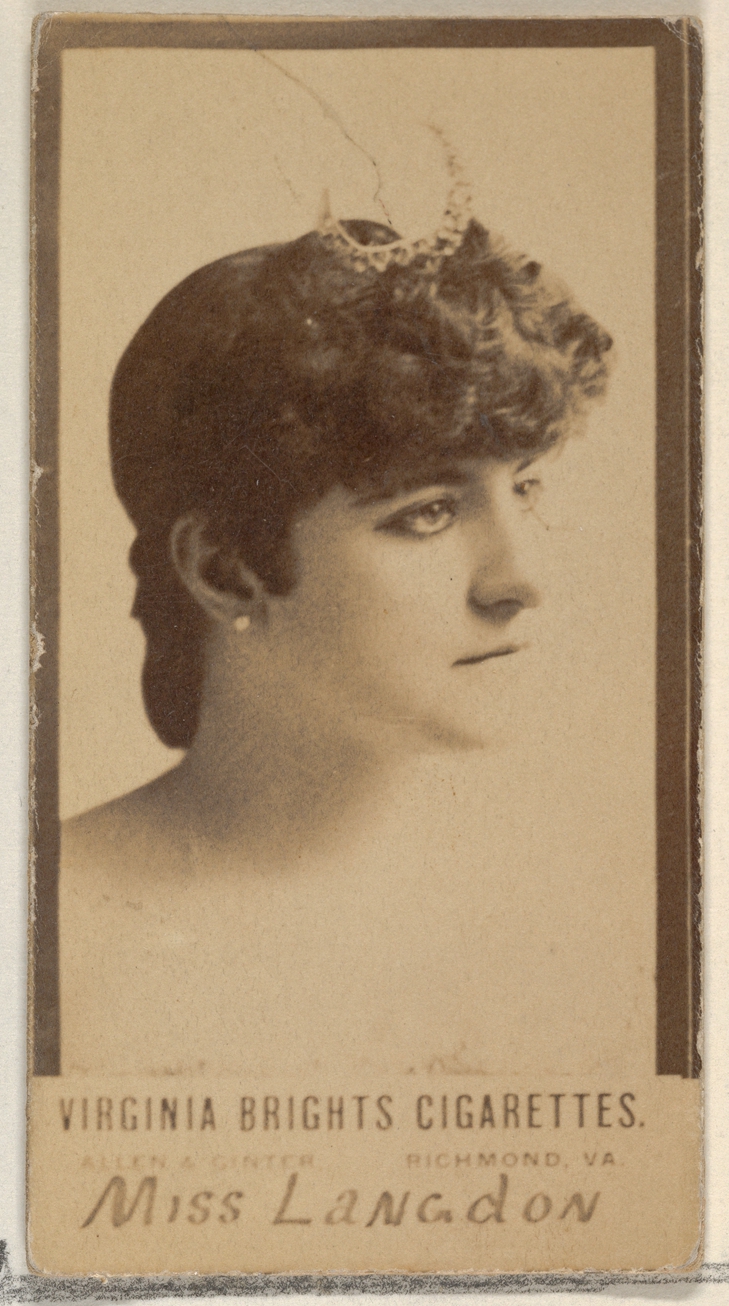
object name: photograph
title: Miss Langdon, from the Actors and Actresses series (N45, Type 3) for Virginia Brights Cigarettes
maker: allen & ginter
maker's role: publisher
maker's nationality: american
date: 1888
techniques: albumen silver print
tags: portraits,women,actresses